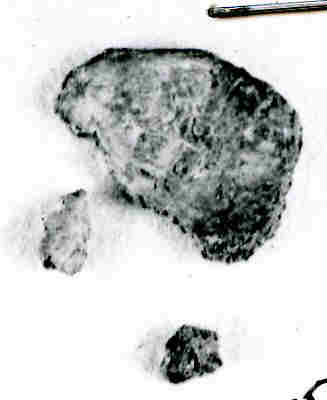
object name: coin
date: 758-768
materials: copper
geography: iran